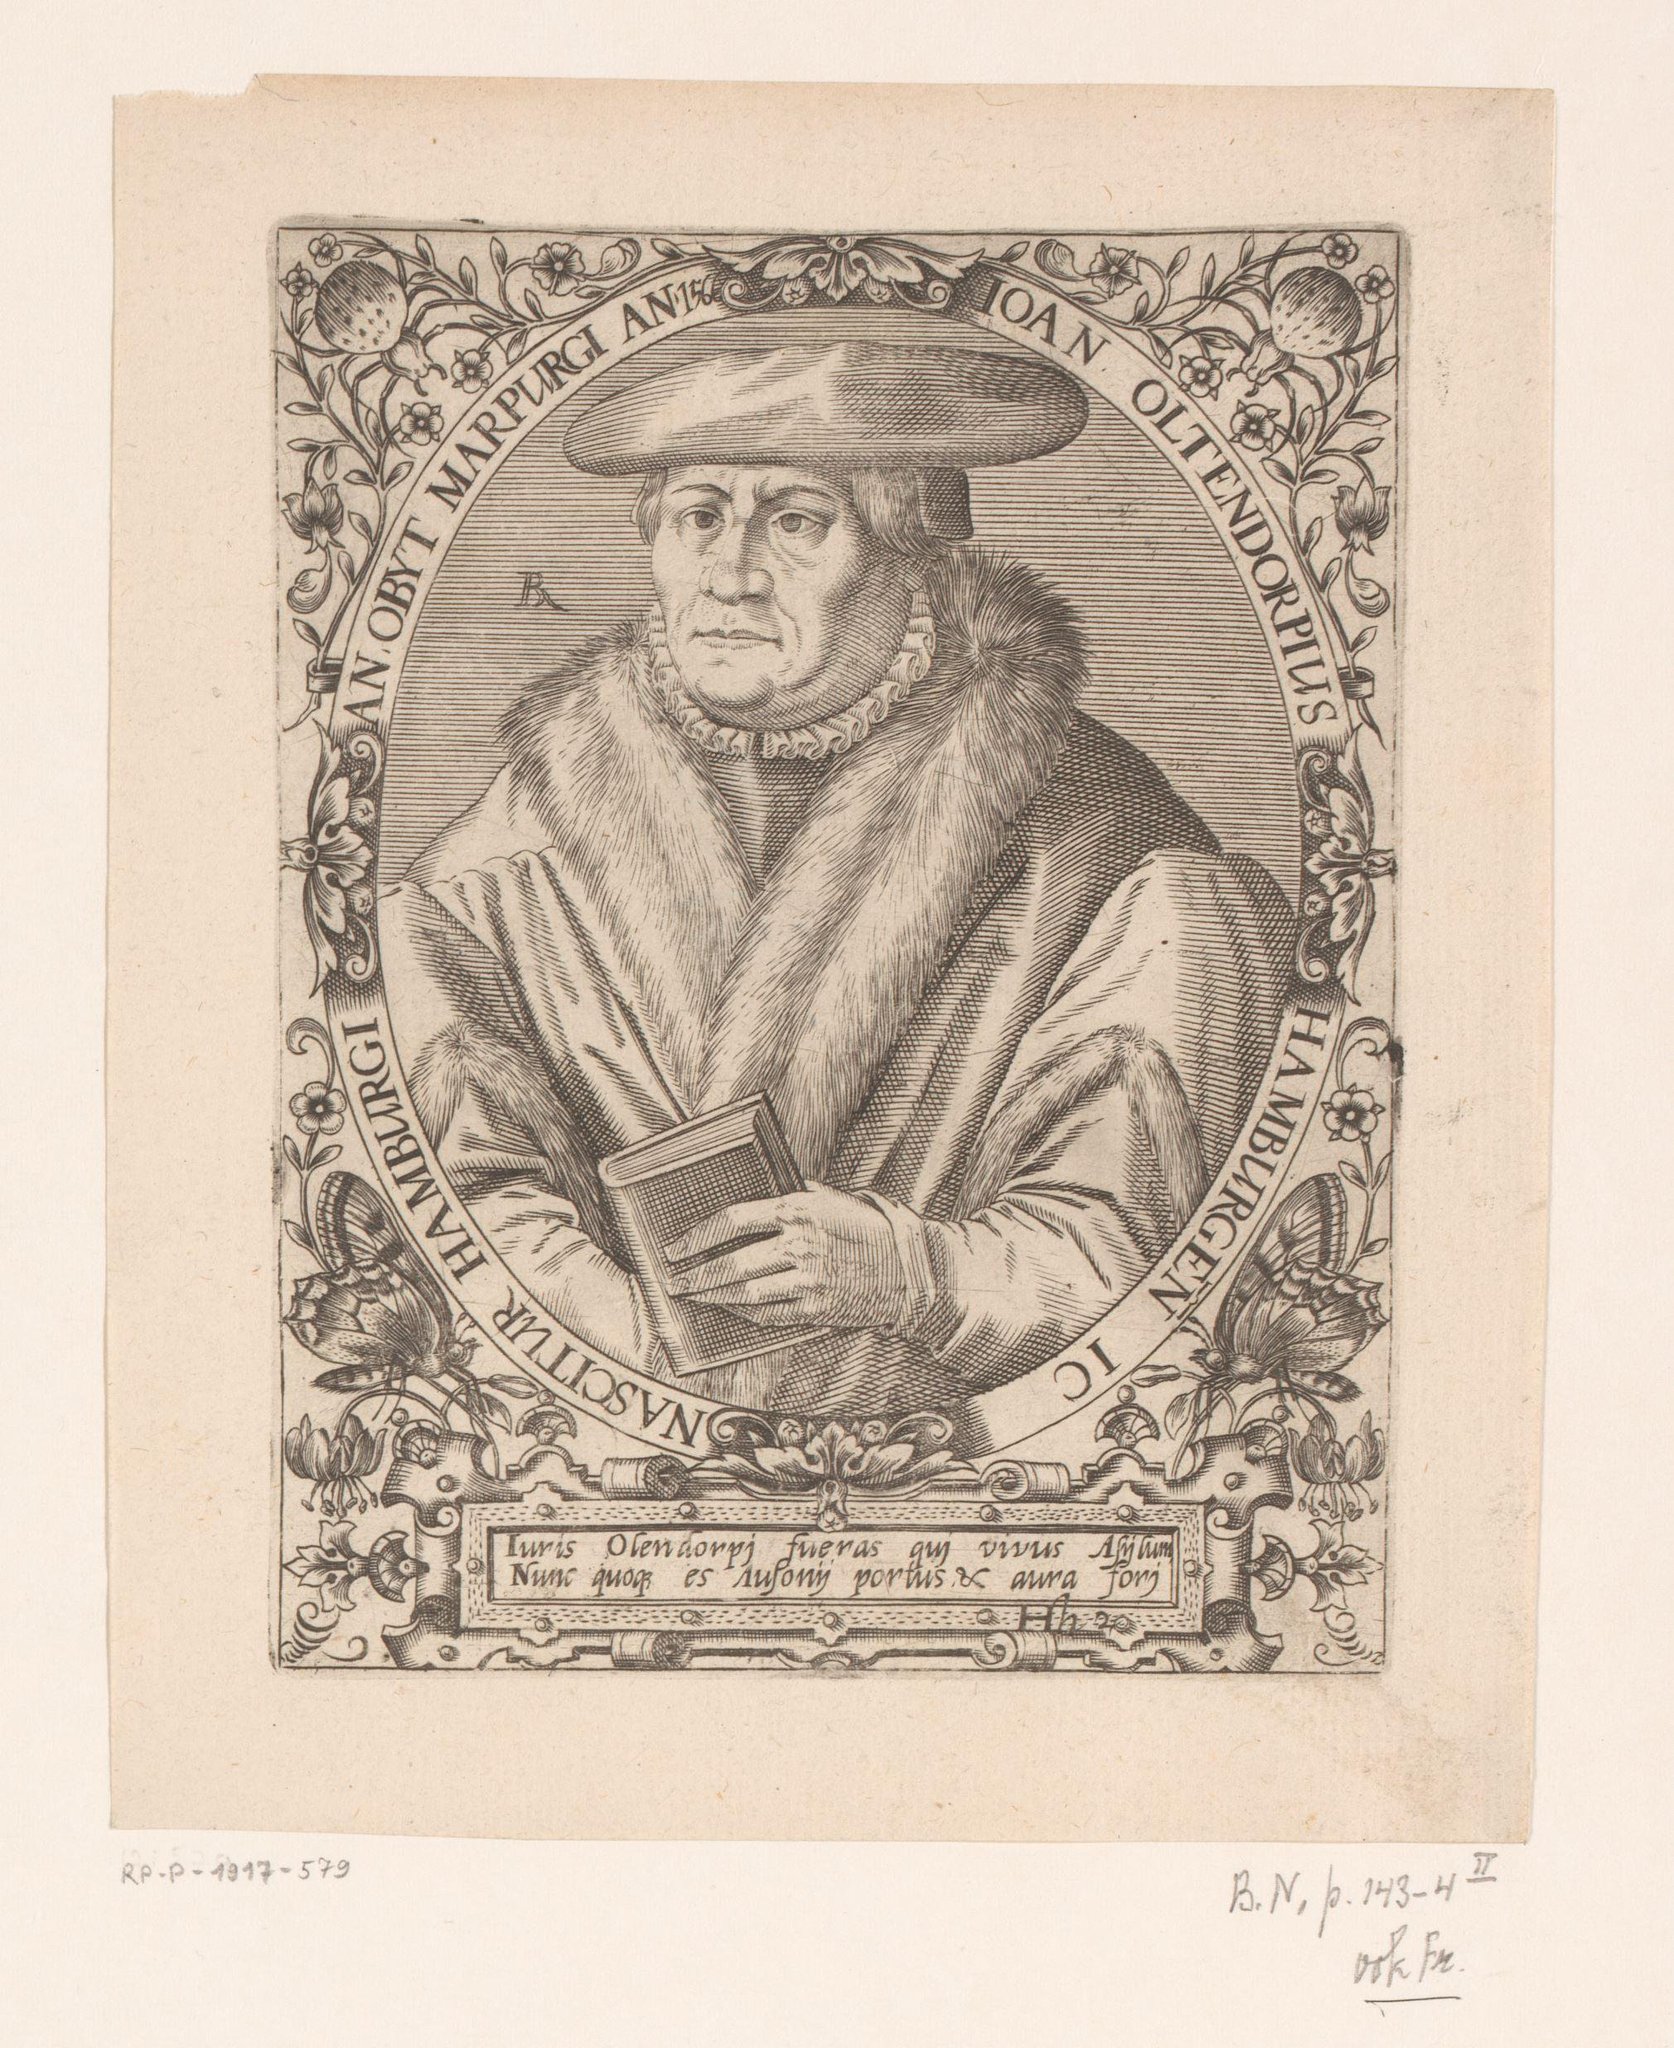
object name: print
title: Portret van Johann Oldendorp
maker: robert boissard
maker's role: print maker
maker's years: 1570-1611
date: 1597-1599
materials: paper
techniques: engraving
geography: france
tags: historical persons, book, spiders, insects: butterfly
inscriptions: collector's mark: Lugt 2228